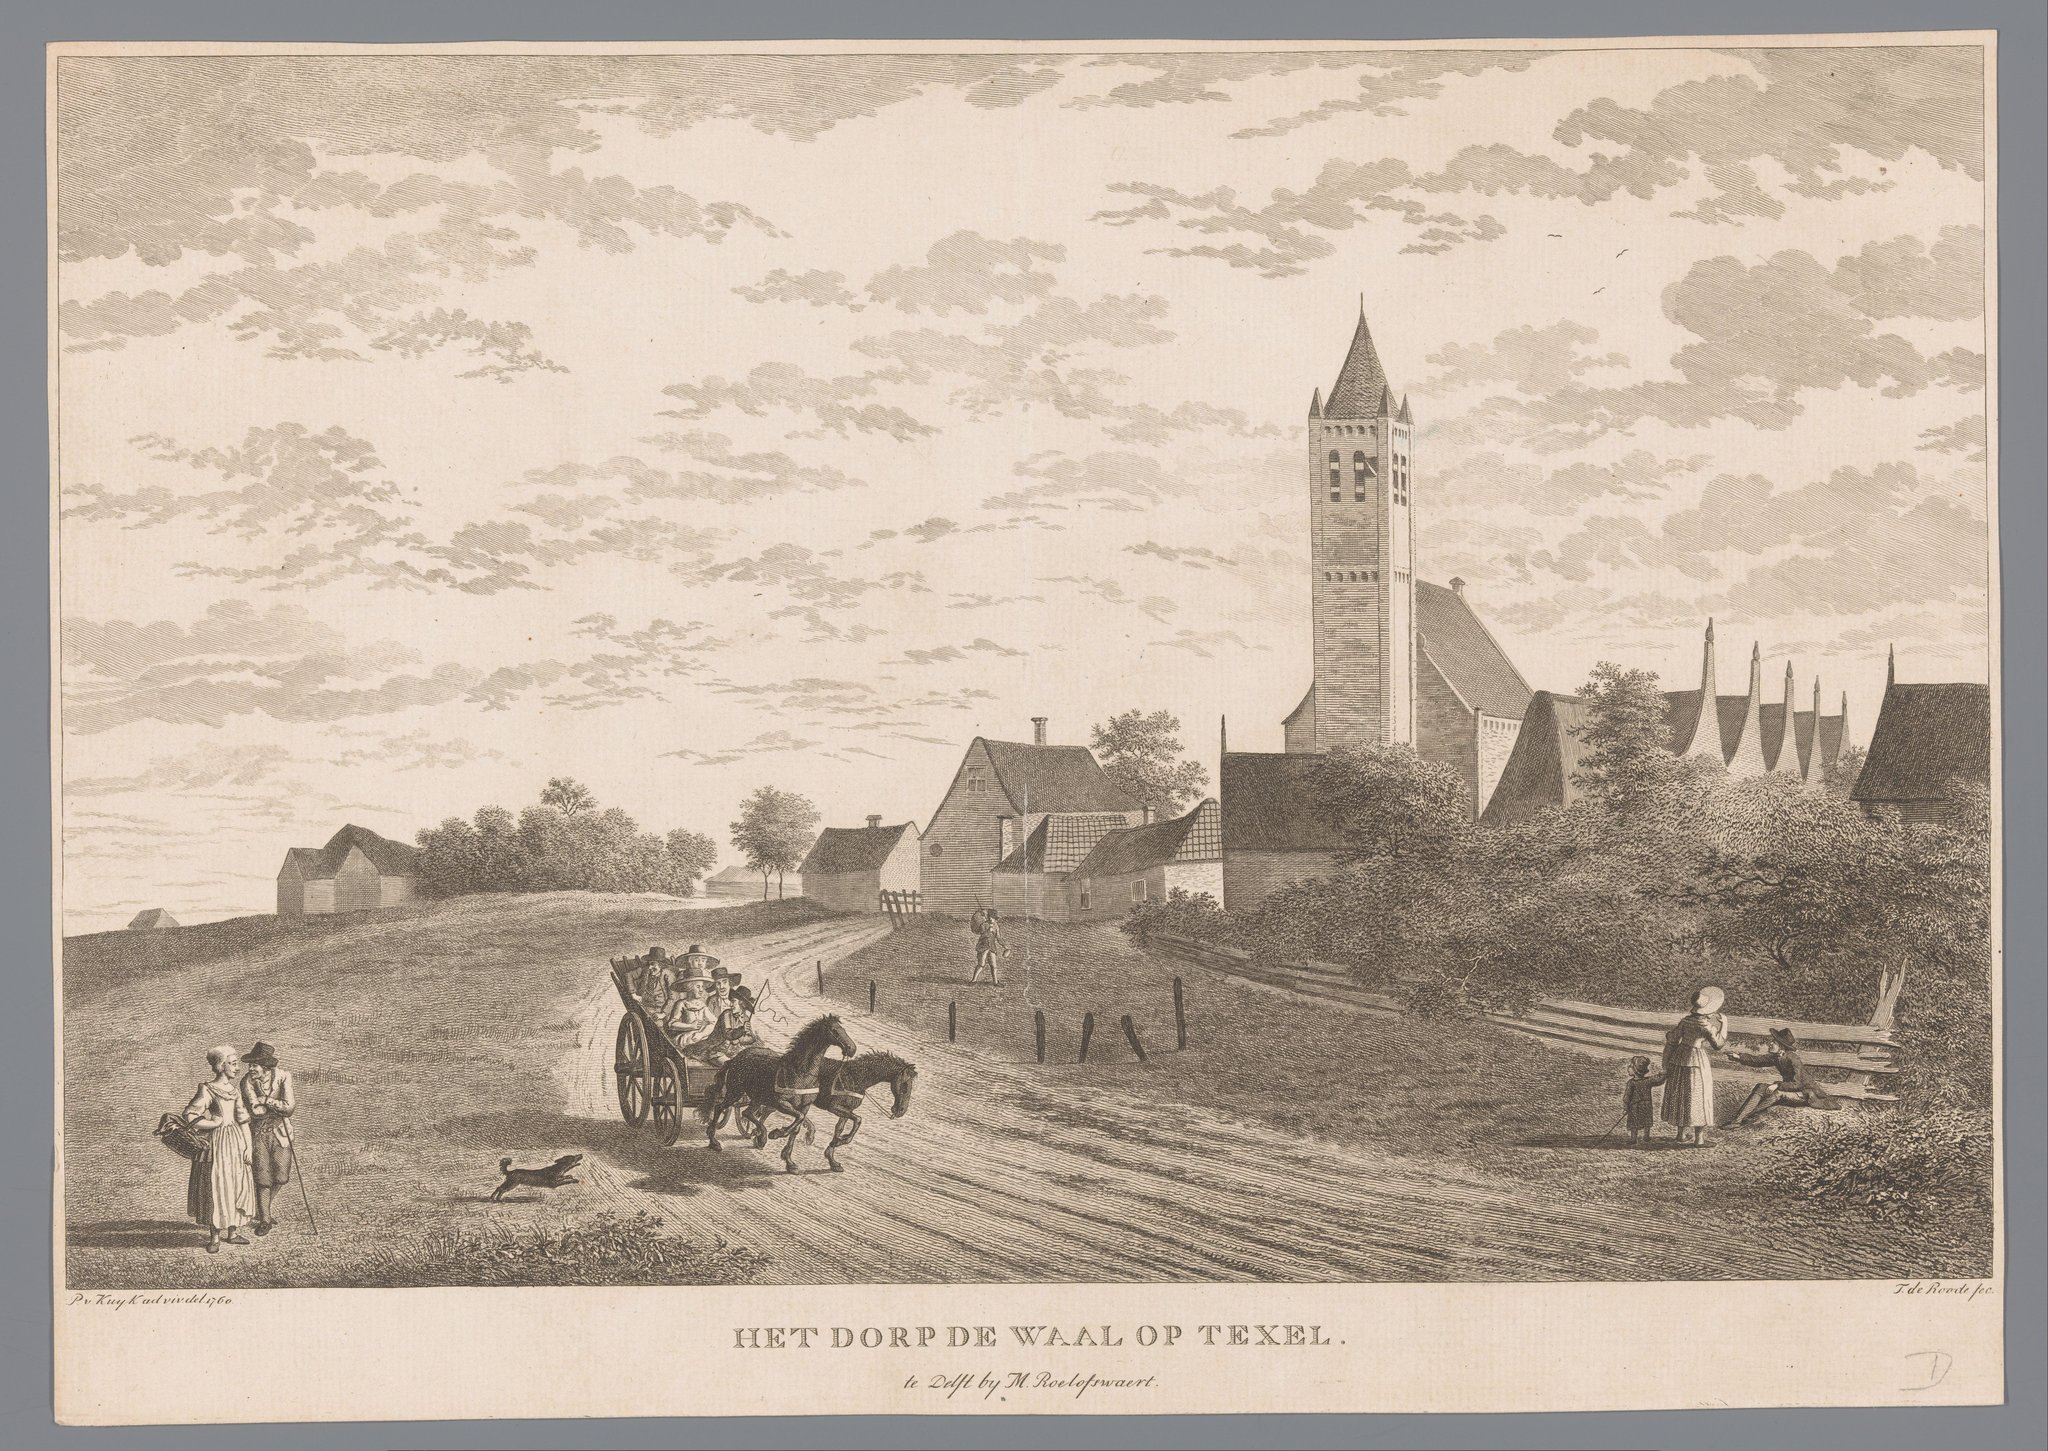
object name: print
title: Gezicht op het dorp De Waal te Texel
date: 1789-1801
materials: paper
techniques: engraving, etching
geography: delft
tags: prospect of village, silhouette of village, four-wheeled, animal-drawn vehicle, e.g.: cab, carriage, coach, church (exterior), 'en route', traveller under way, dog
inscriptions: collector's mark: Lugt 2166, collector's mark: Lugt 2760